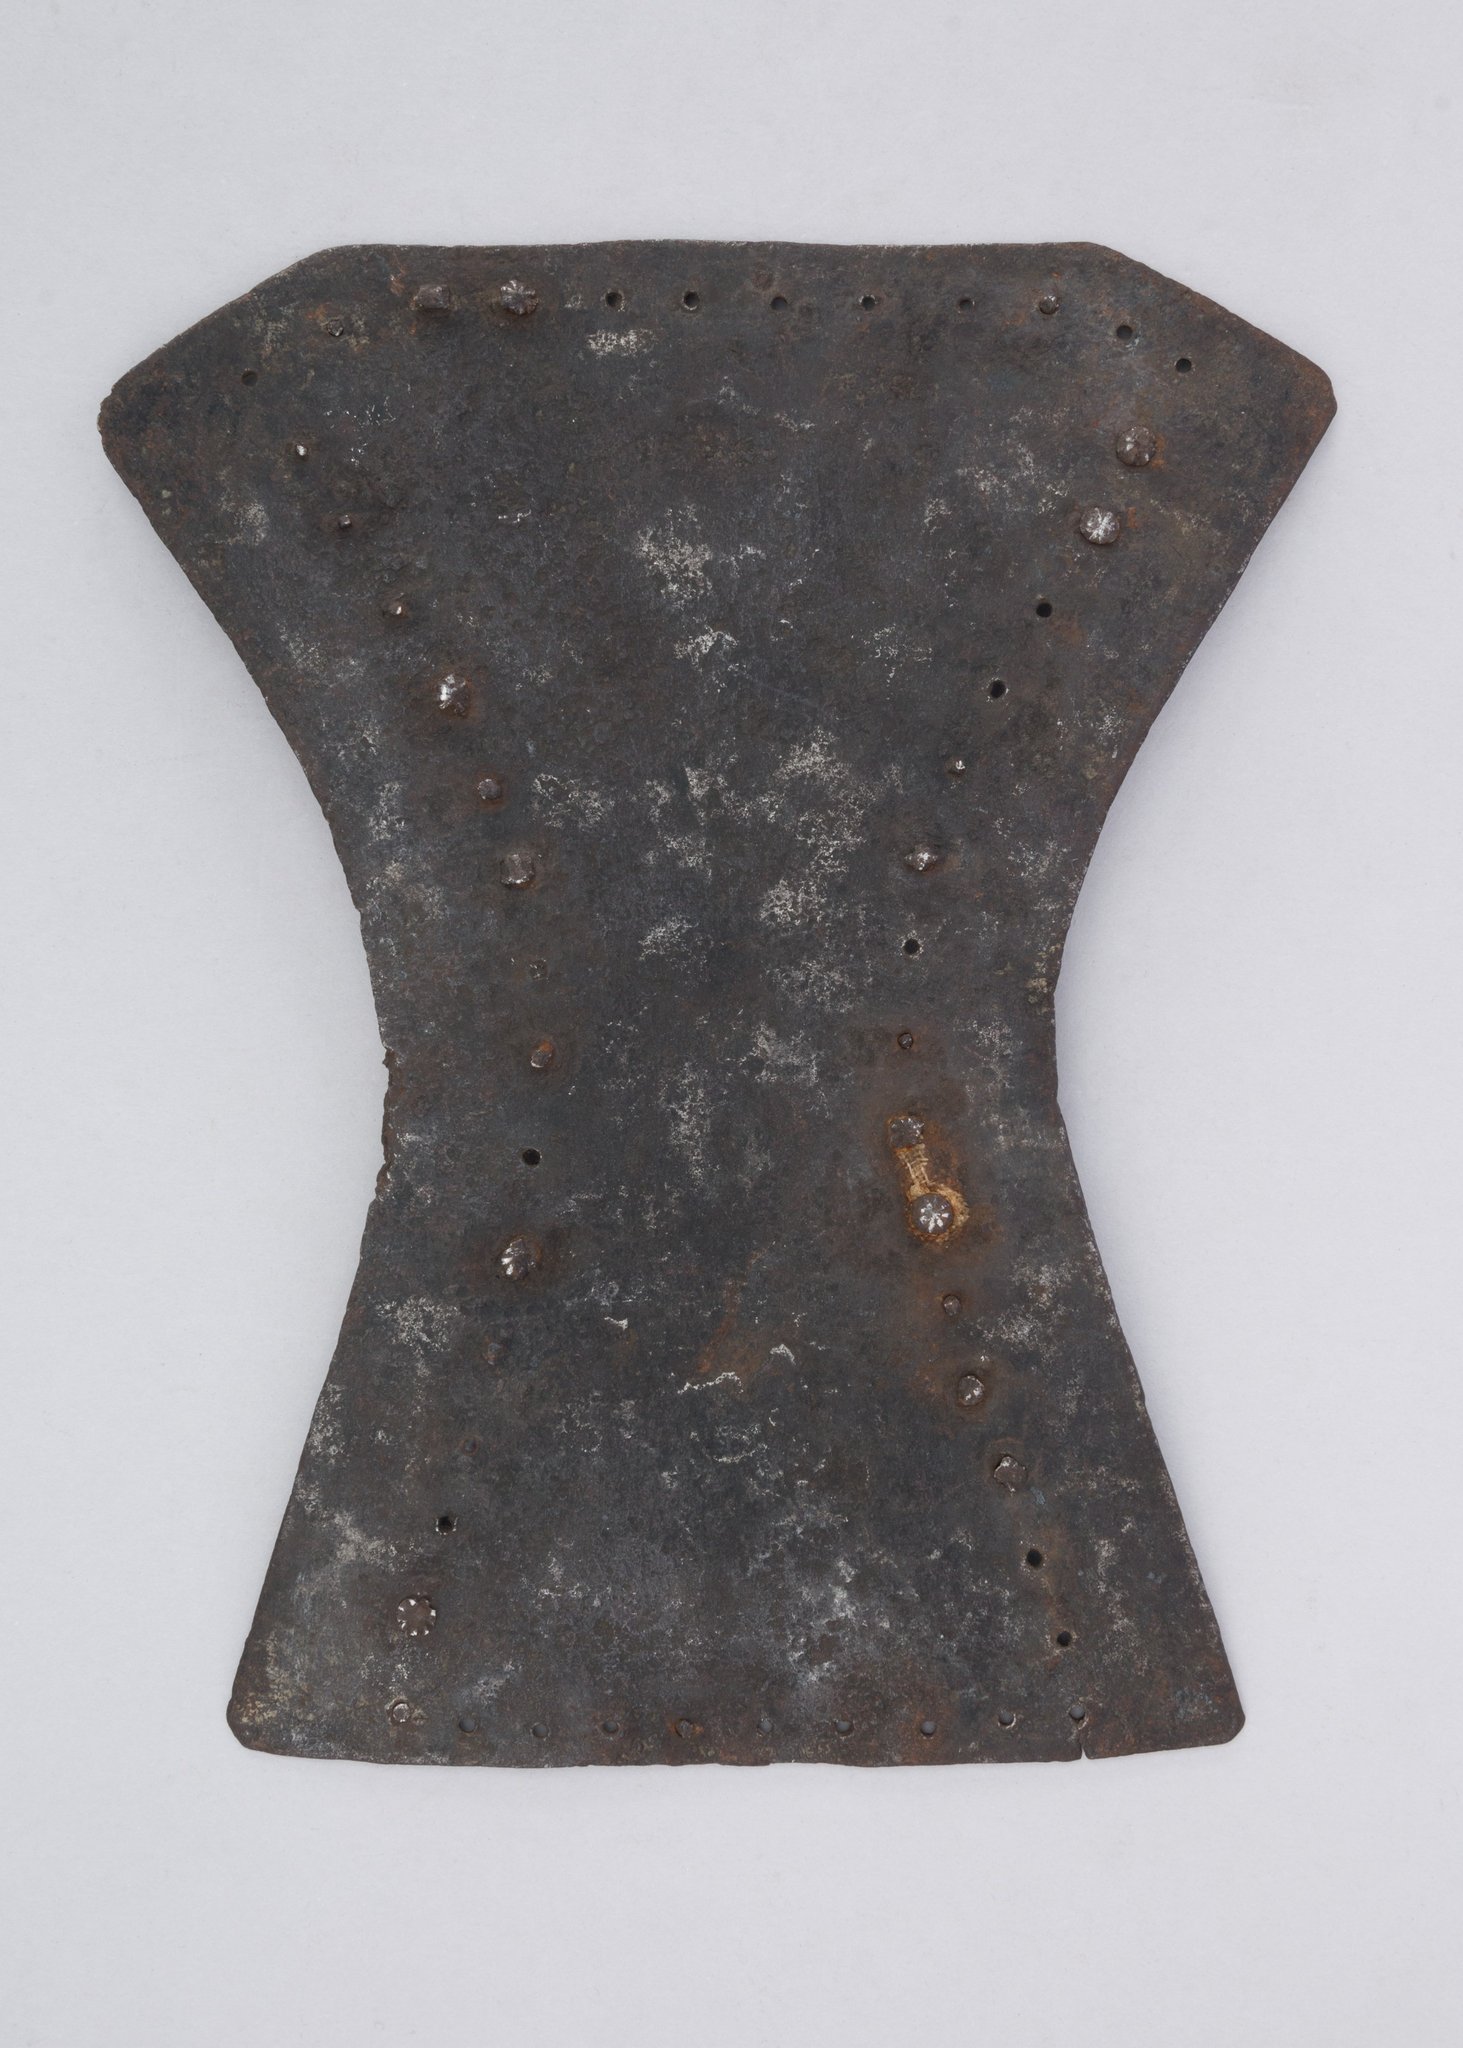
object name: brigandine plate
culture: italian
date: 1400-1450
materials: metal, textile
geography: italy